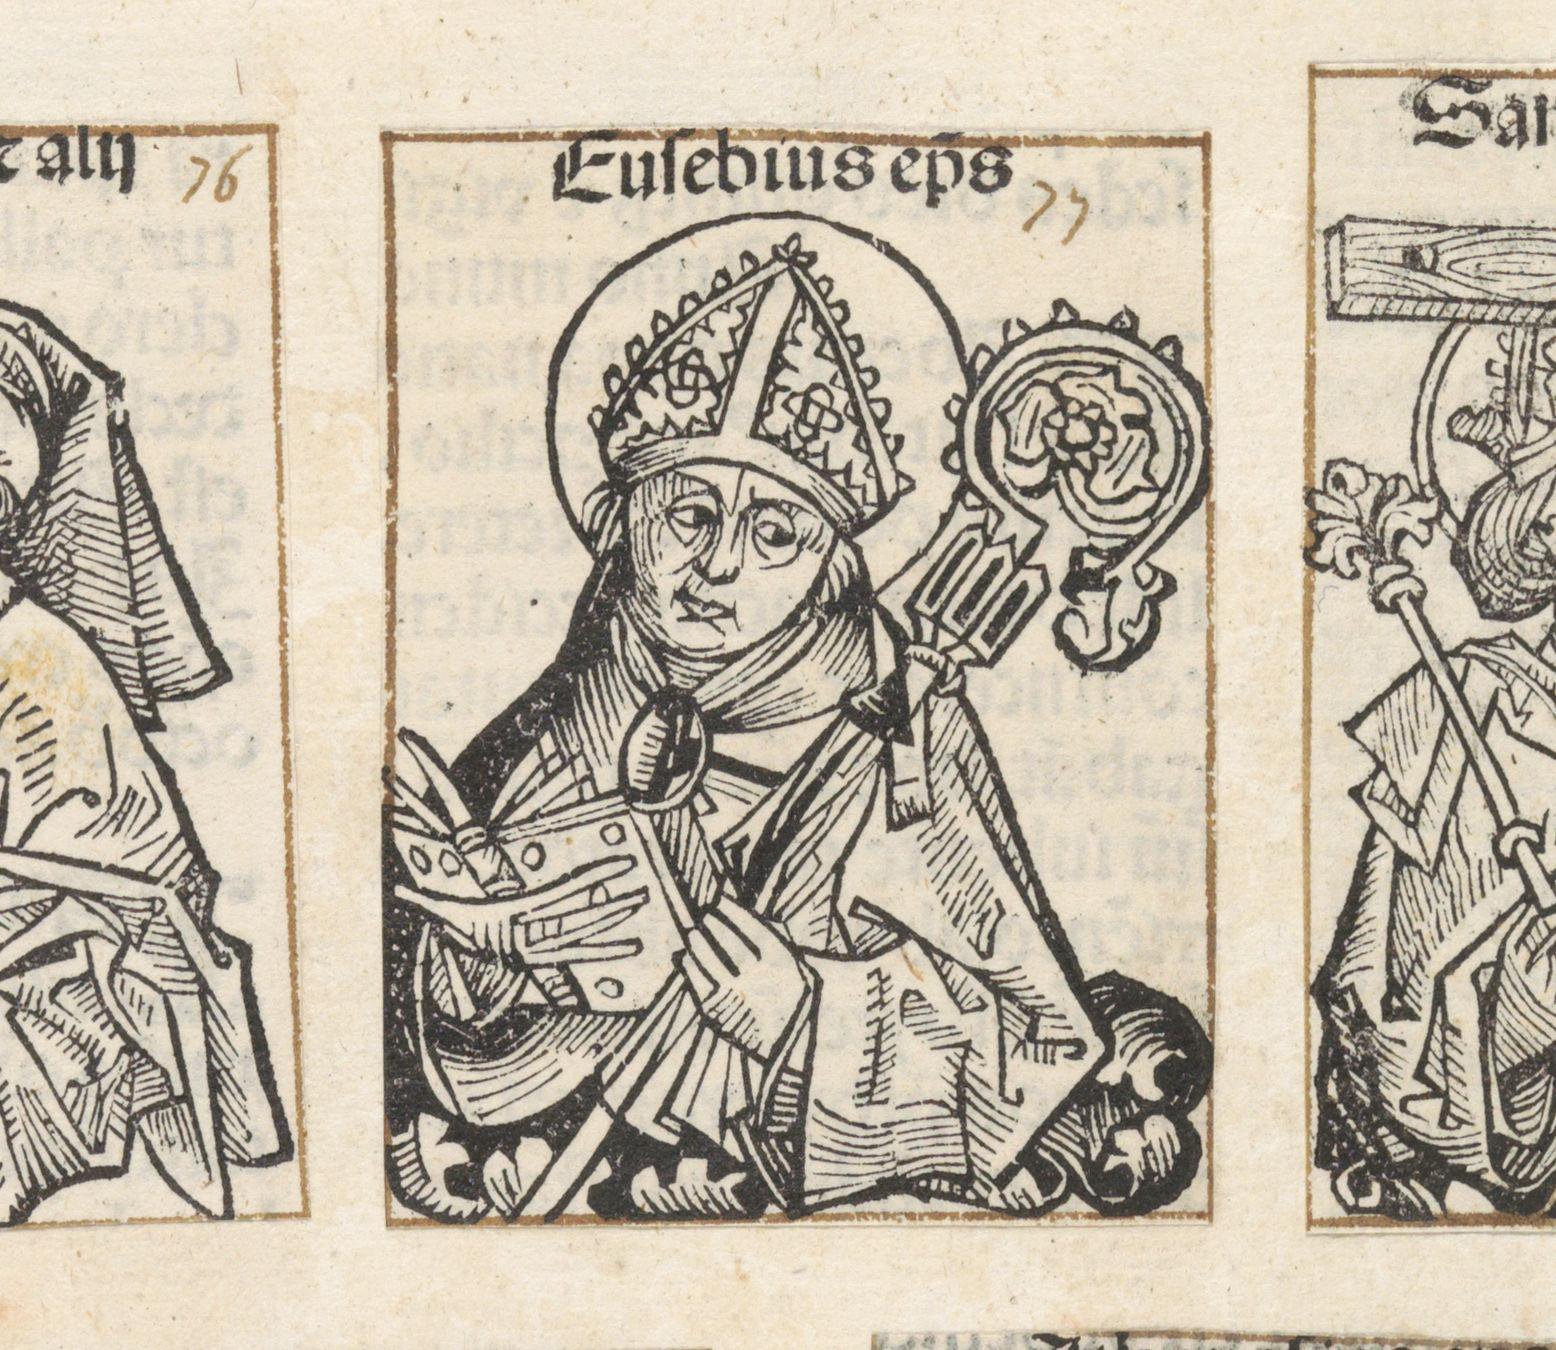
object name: print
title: Eusebius van Caesarea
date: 1493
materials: paper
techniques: letterpress printing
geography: nuremberg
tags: archbishop, bishop, etc. (roman catholic)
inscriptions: inscription: ‘77’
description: De houtsnede wordt herhaaldelijk gebruikt als boekillustratie in de Liber Chronicarum (of Neurenbergkroniek) van Hartmann Schedel, verschenen in het Latijn en Duits in 1493. Zie de Latijnse uitgave, folio 128r.